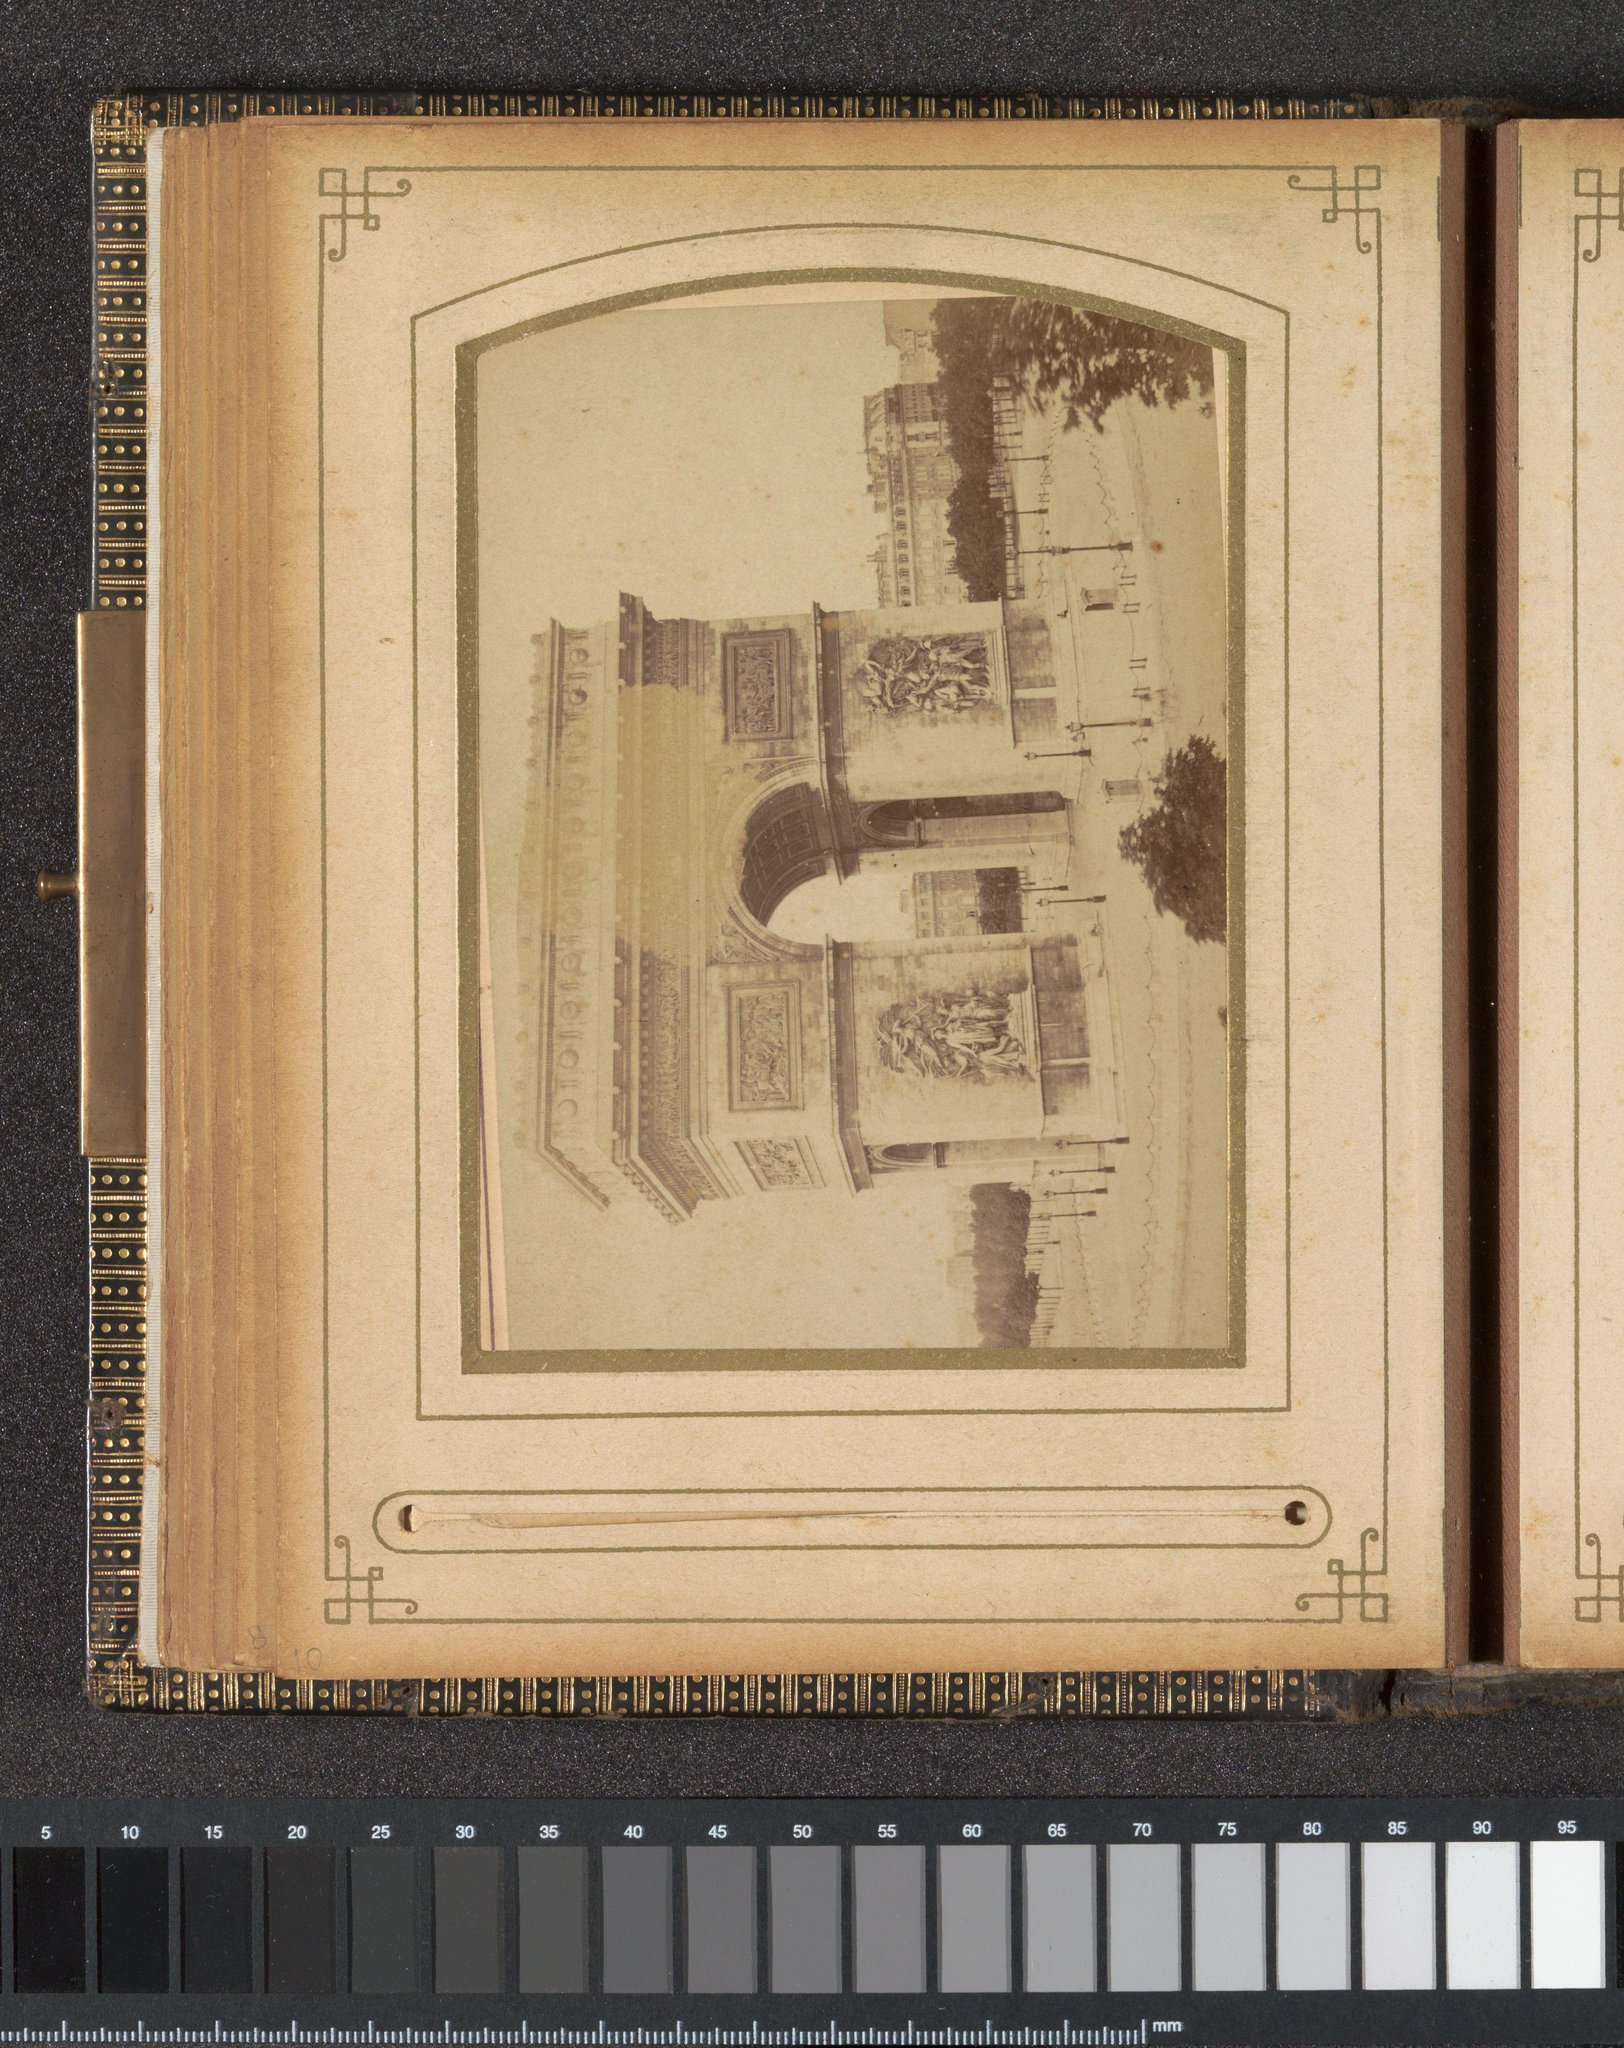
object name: photograph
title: Arc de Triomphe in Parijs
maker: Anonymous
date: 1870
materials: cardboard, paper, photographic support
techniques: albumen print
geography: paris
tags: triumphal arch, paris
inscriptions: inscription: ‘Arc de triomphe’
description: Onderdeel van Fotoalbum met kabinetfoto's van bezienswaardigheden in Parijs.